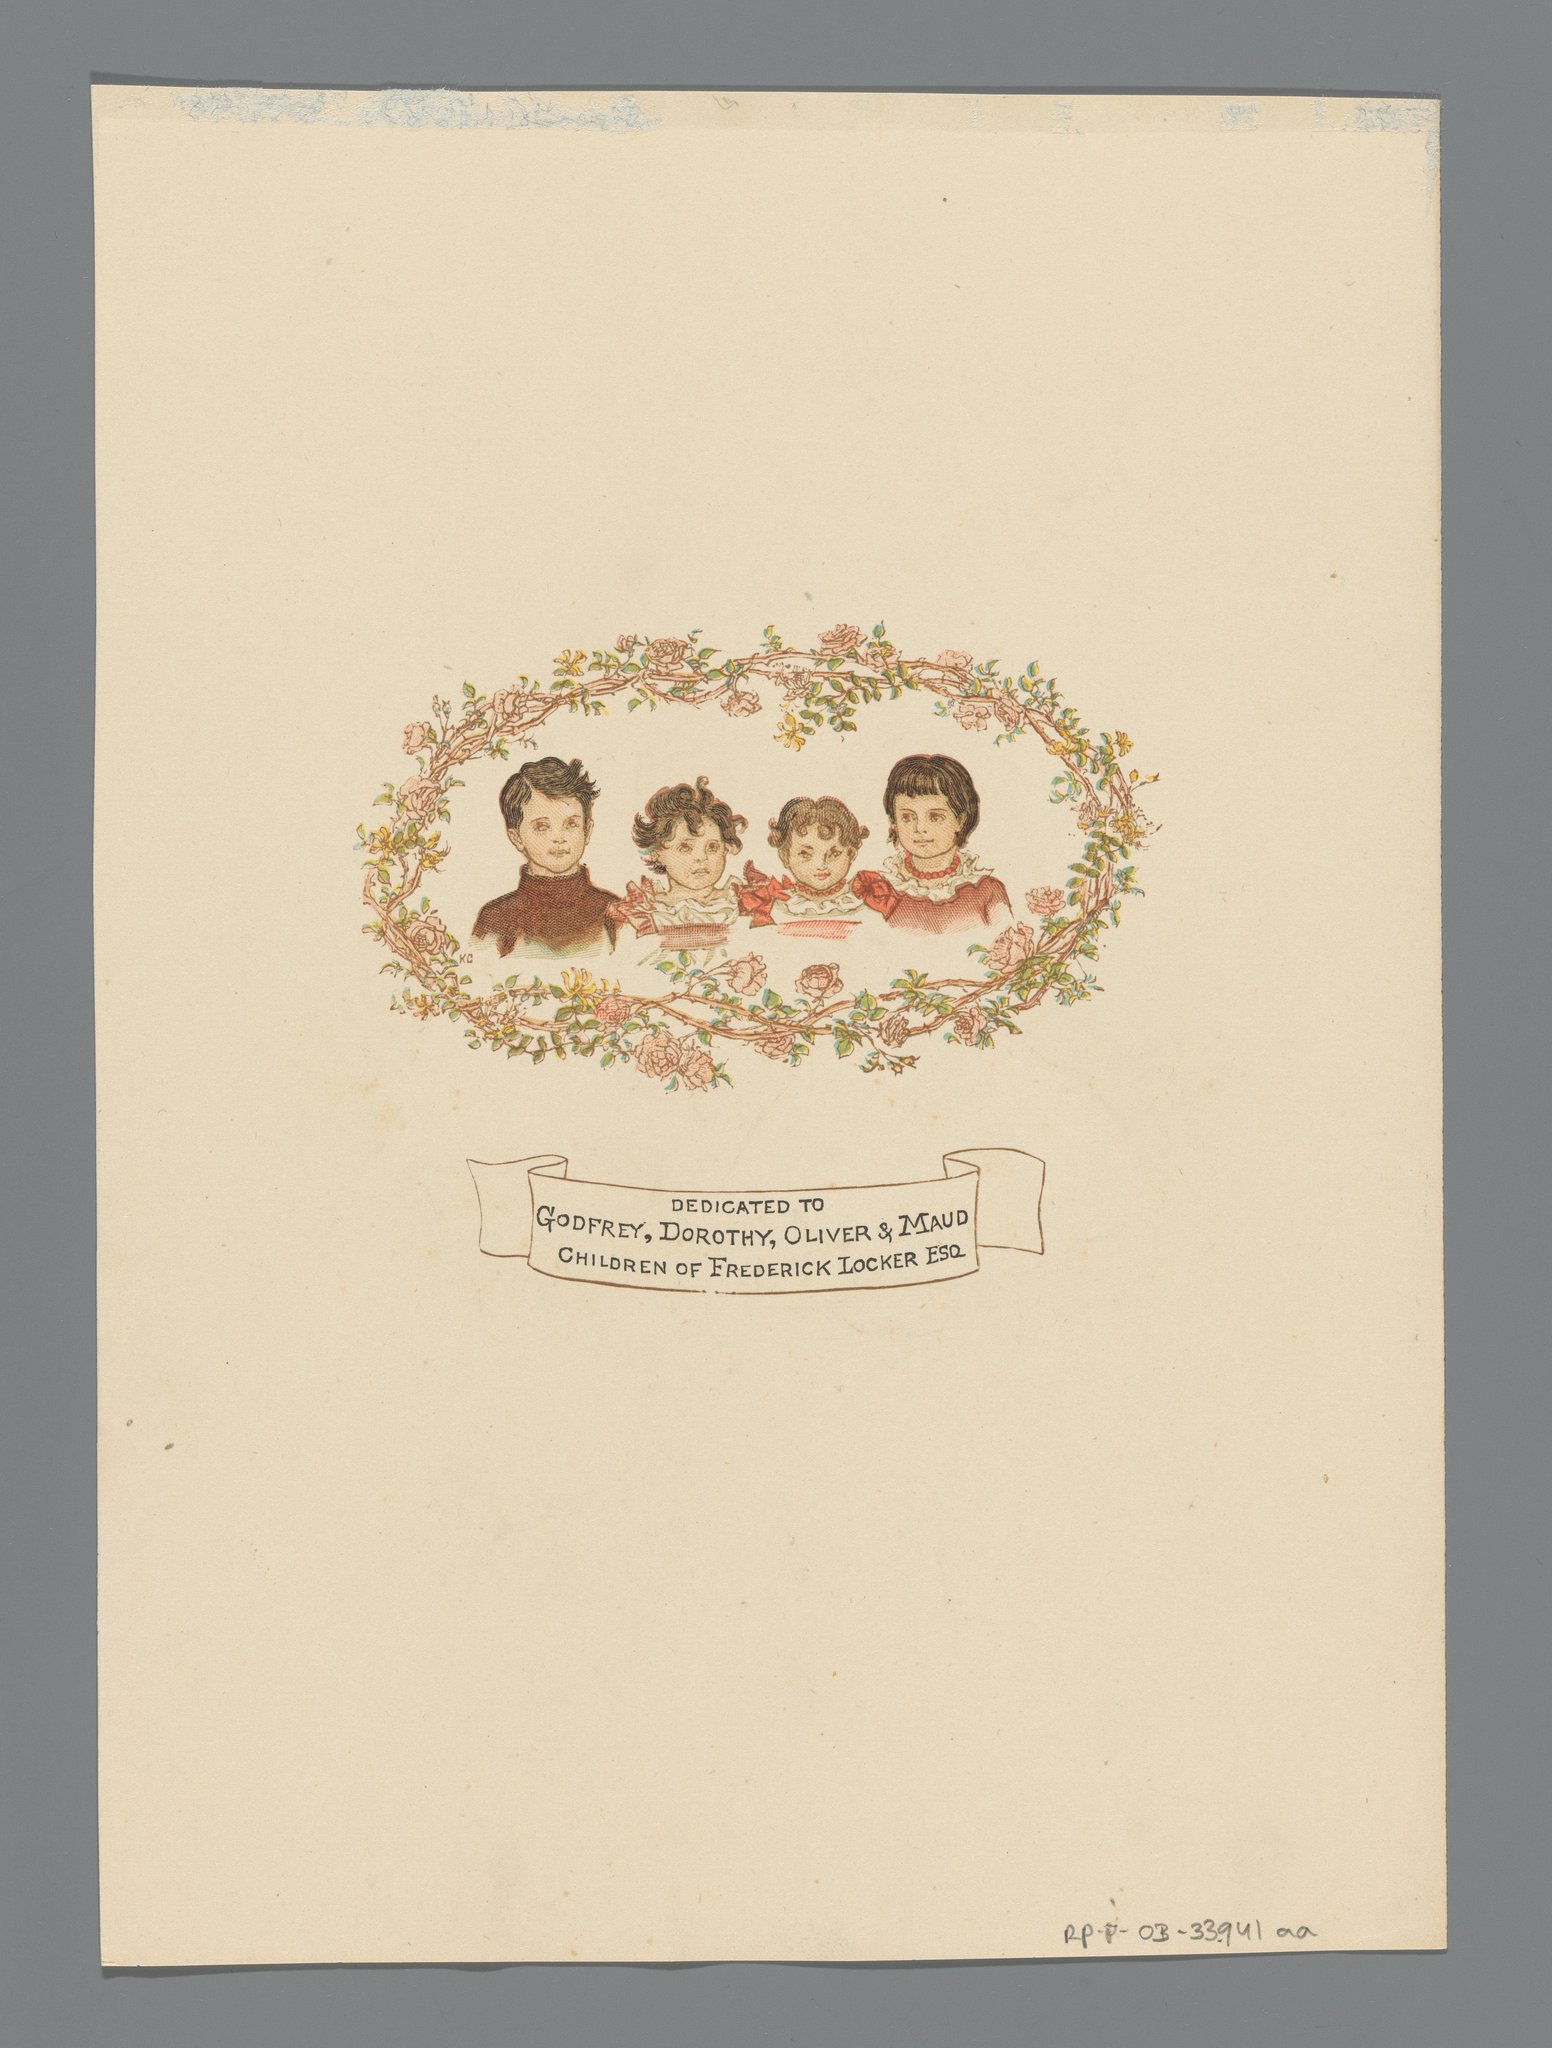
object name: book illustration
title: Vier kinderen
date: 1883-1927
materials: paper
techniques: wood engraving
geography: london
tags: child (+ four persons), historical persons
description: Prent uit: Jane en Ann Taylor. Little Ann and other poems. Londen: George Routledge & Sons, [1883]. Of een latere uitgave.